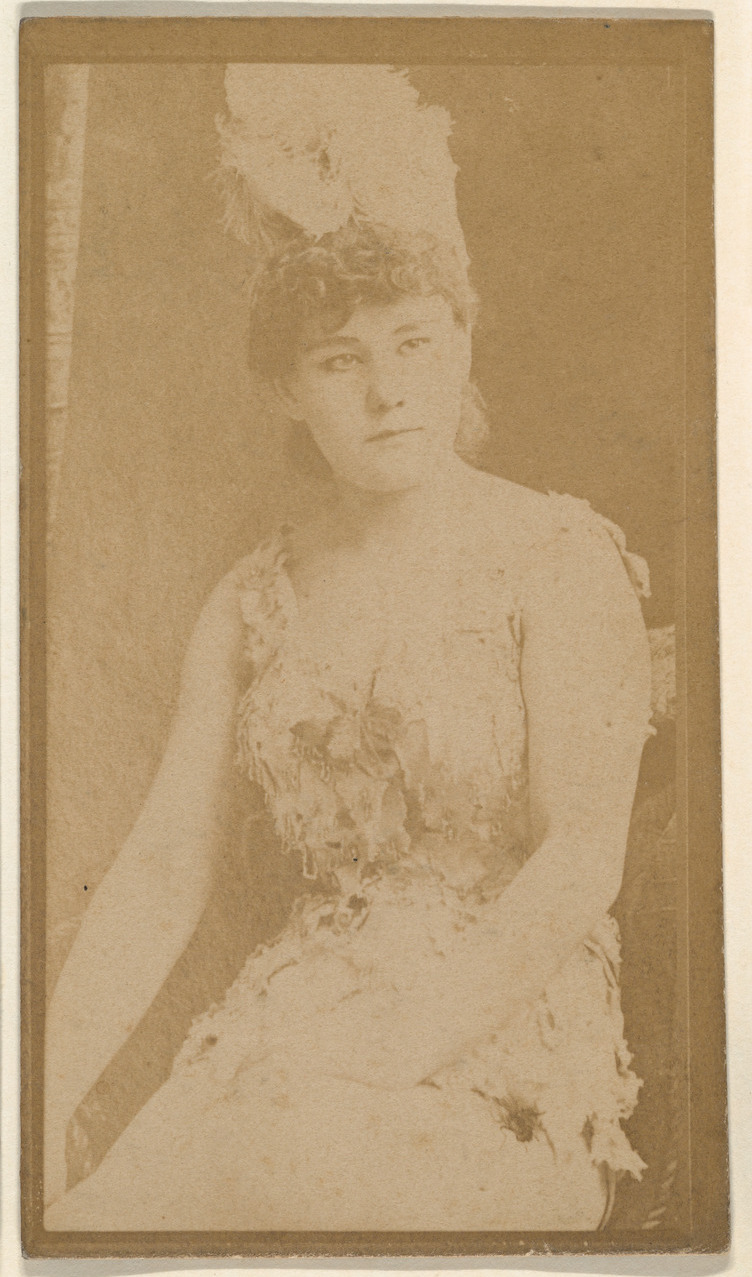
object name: photograph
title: Seated actress wearing feathered hat, from the Actresses series (N668)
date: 1888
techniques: albumen silver print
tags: portraits,women,actresses